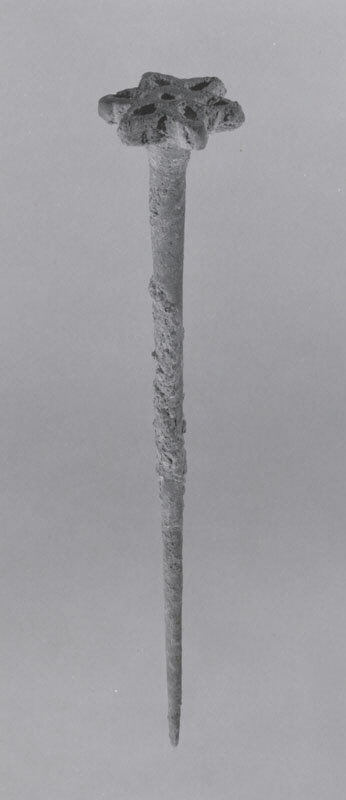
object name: pin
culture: bactria-margiana archaeological complex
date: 2333-1668 BCE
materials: copper alloy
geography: bactria-margiana